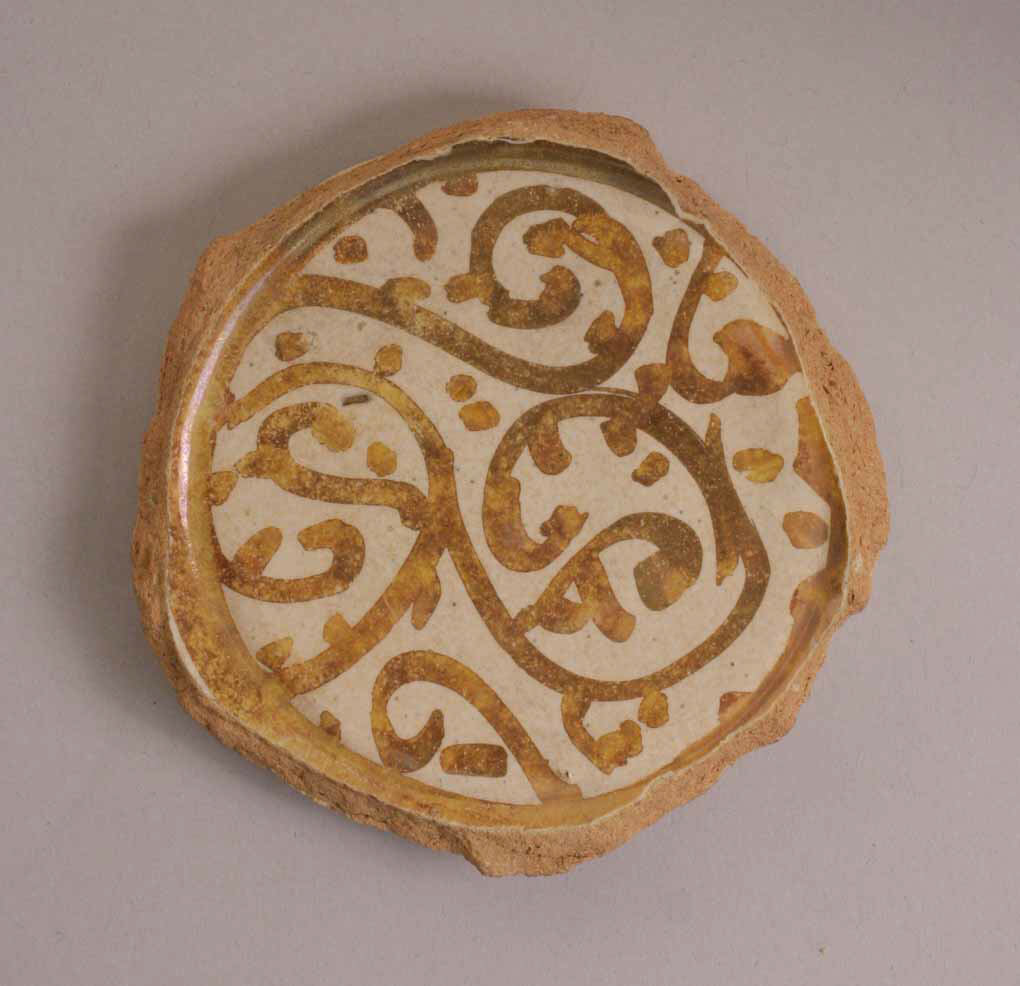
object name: ceramic fragment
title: Fragment of a Bowl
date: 901-1200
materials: earthenware, glaze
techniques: luster painting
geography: egypt